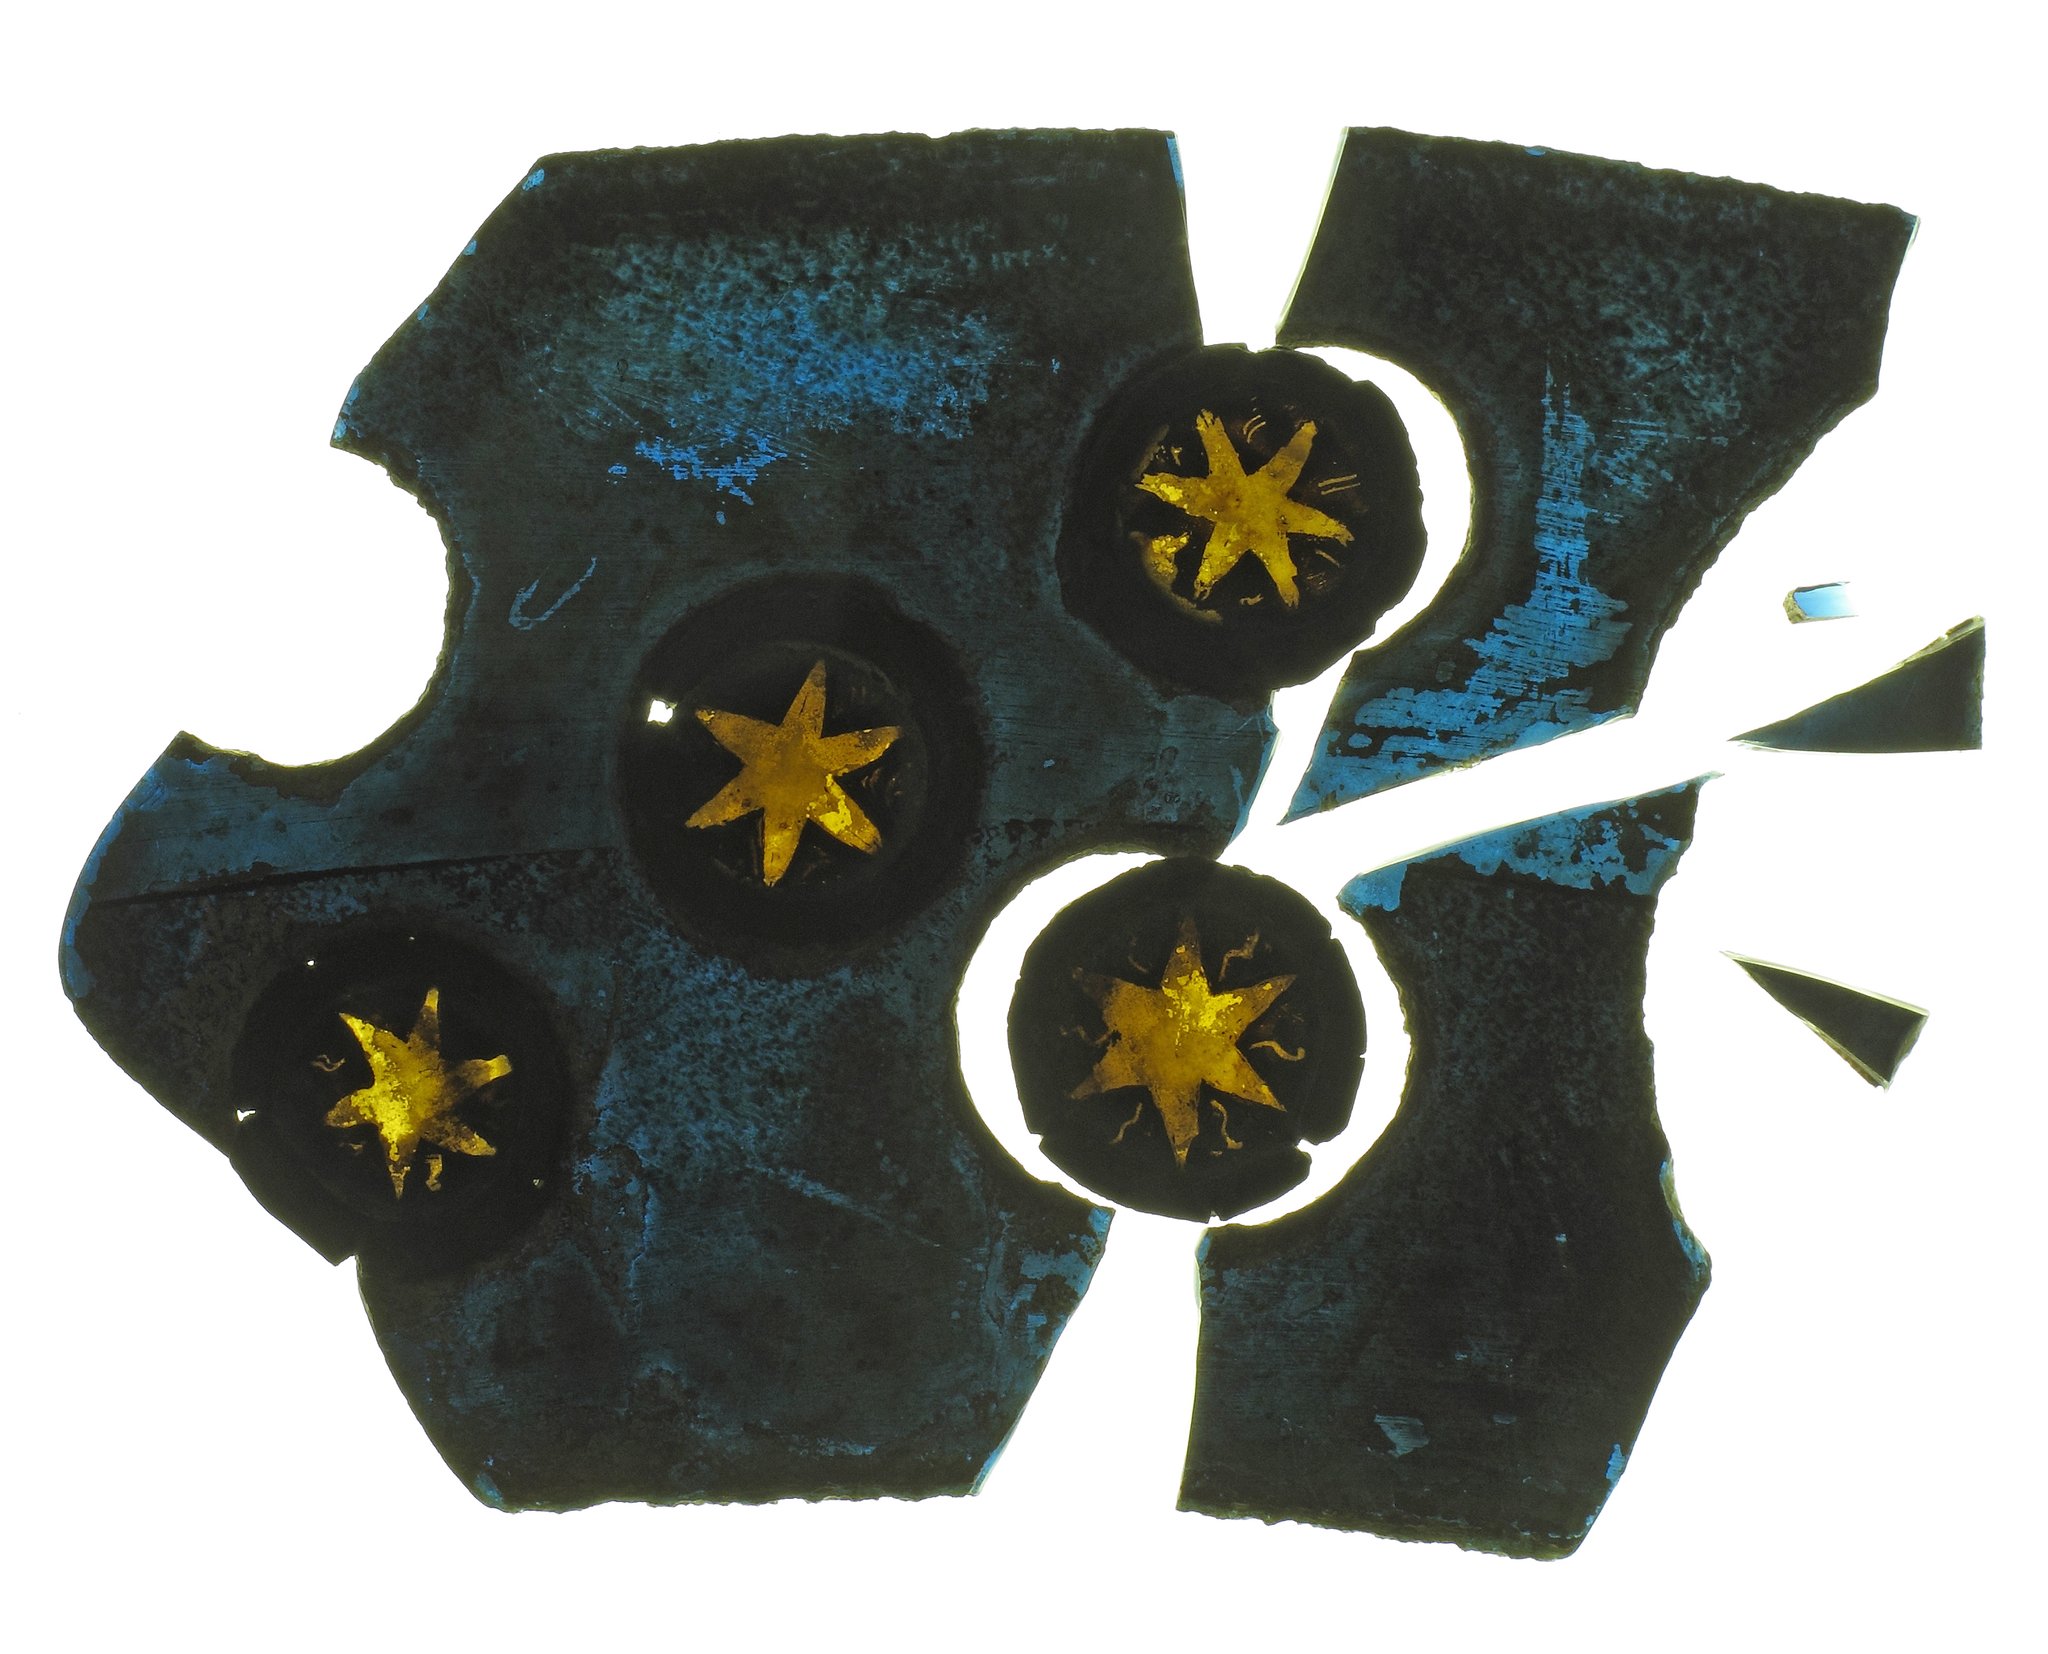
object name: fragment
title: Glass Fragment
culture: french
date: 1301-1400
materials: glass, metal